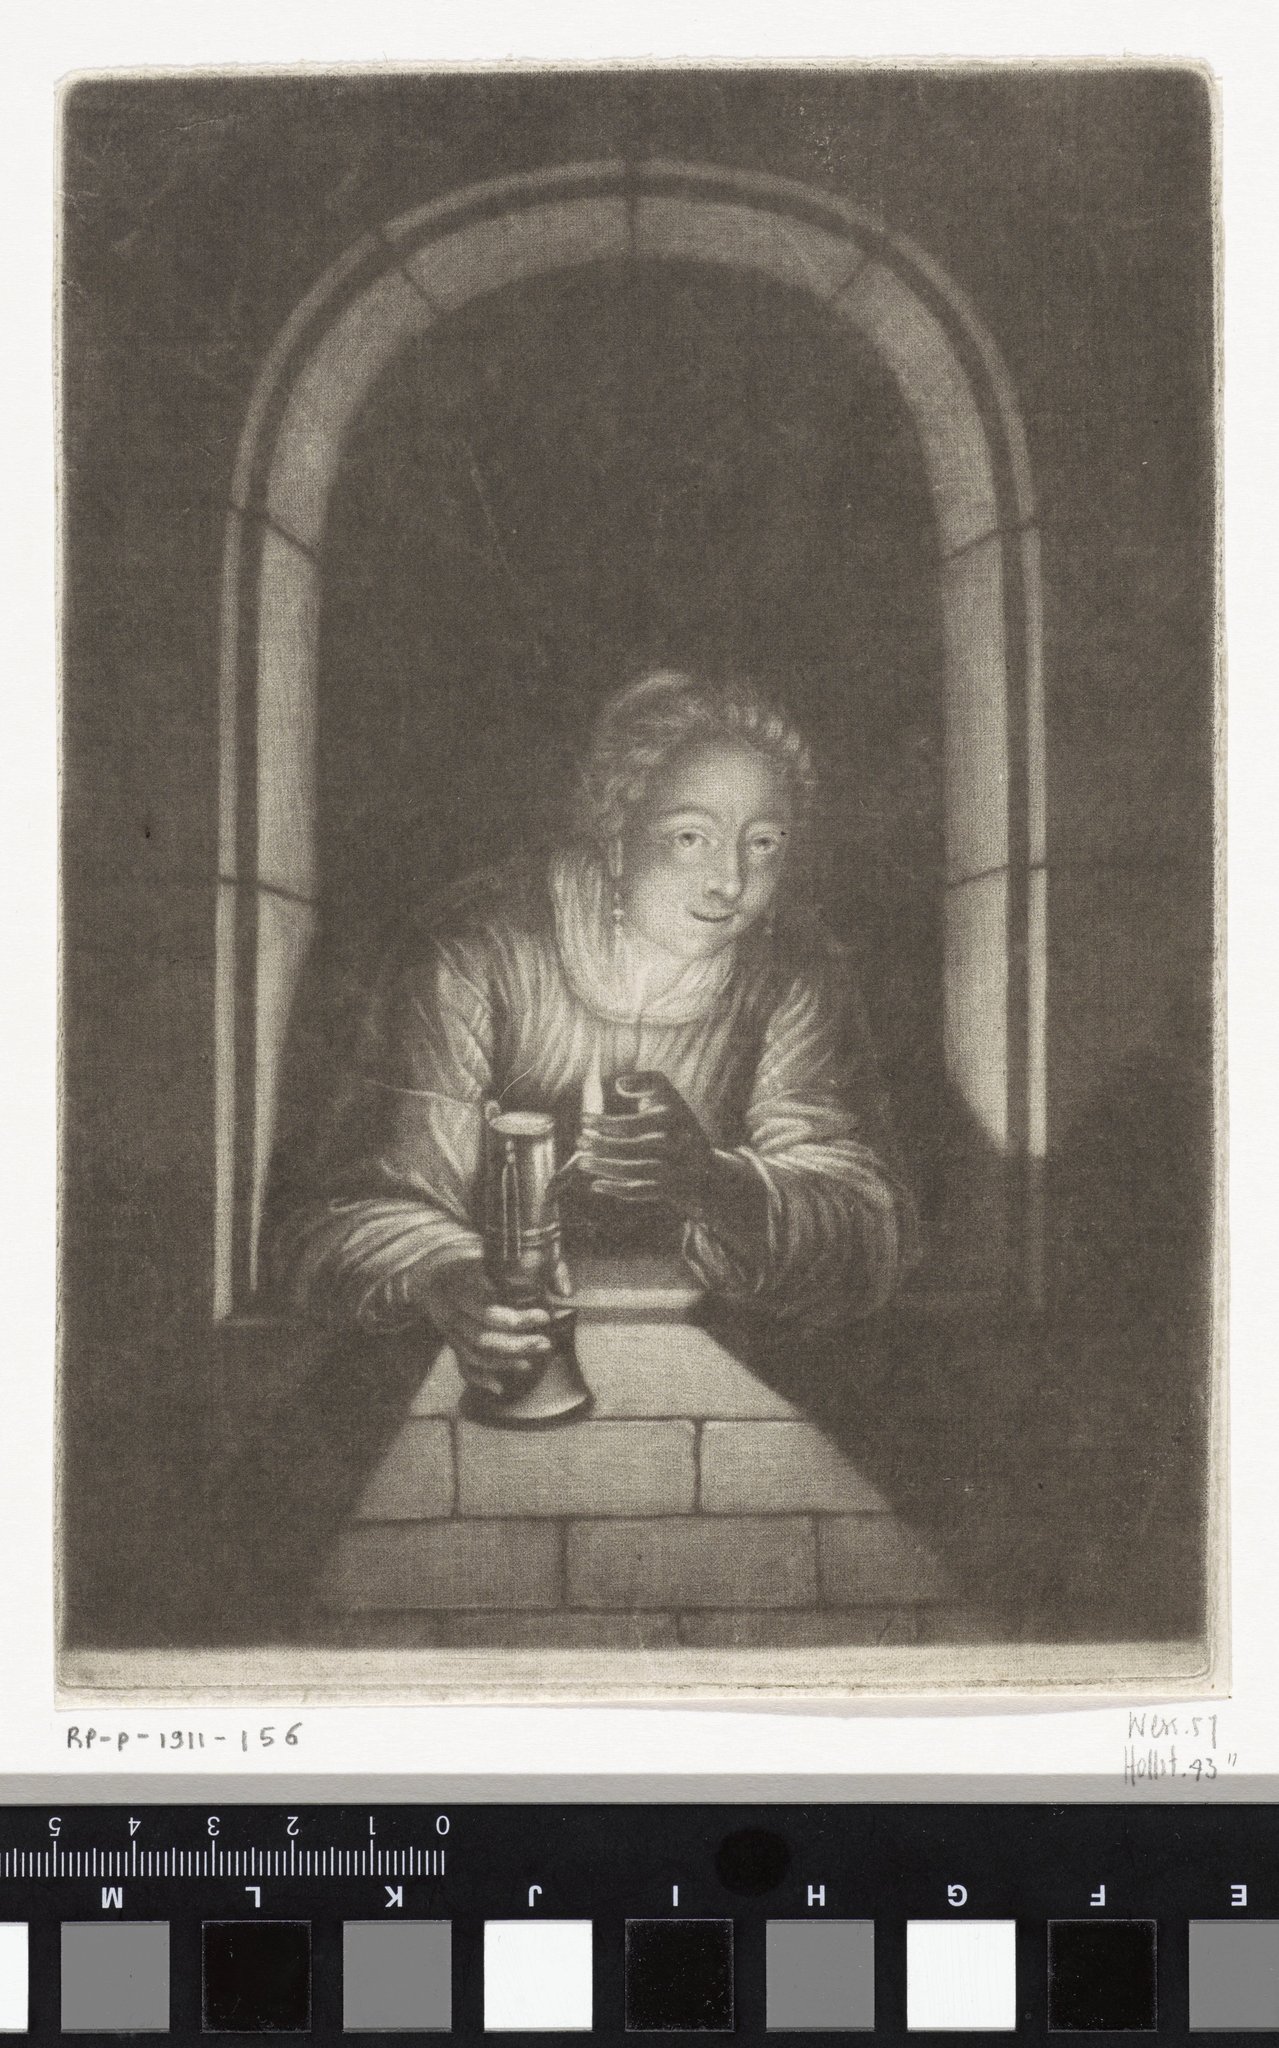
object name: print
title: Vrouw met een olielamp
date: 1662-1726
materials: paper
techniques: mezzotint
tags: oil-lamp, human figure at (open) window, seen from outside - aa - feigned window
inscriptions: collector's mark: Lugt 2228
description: Een jonge vrouw leunt met een brandende olielamp uit een venster.